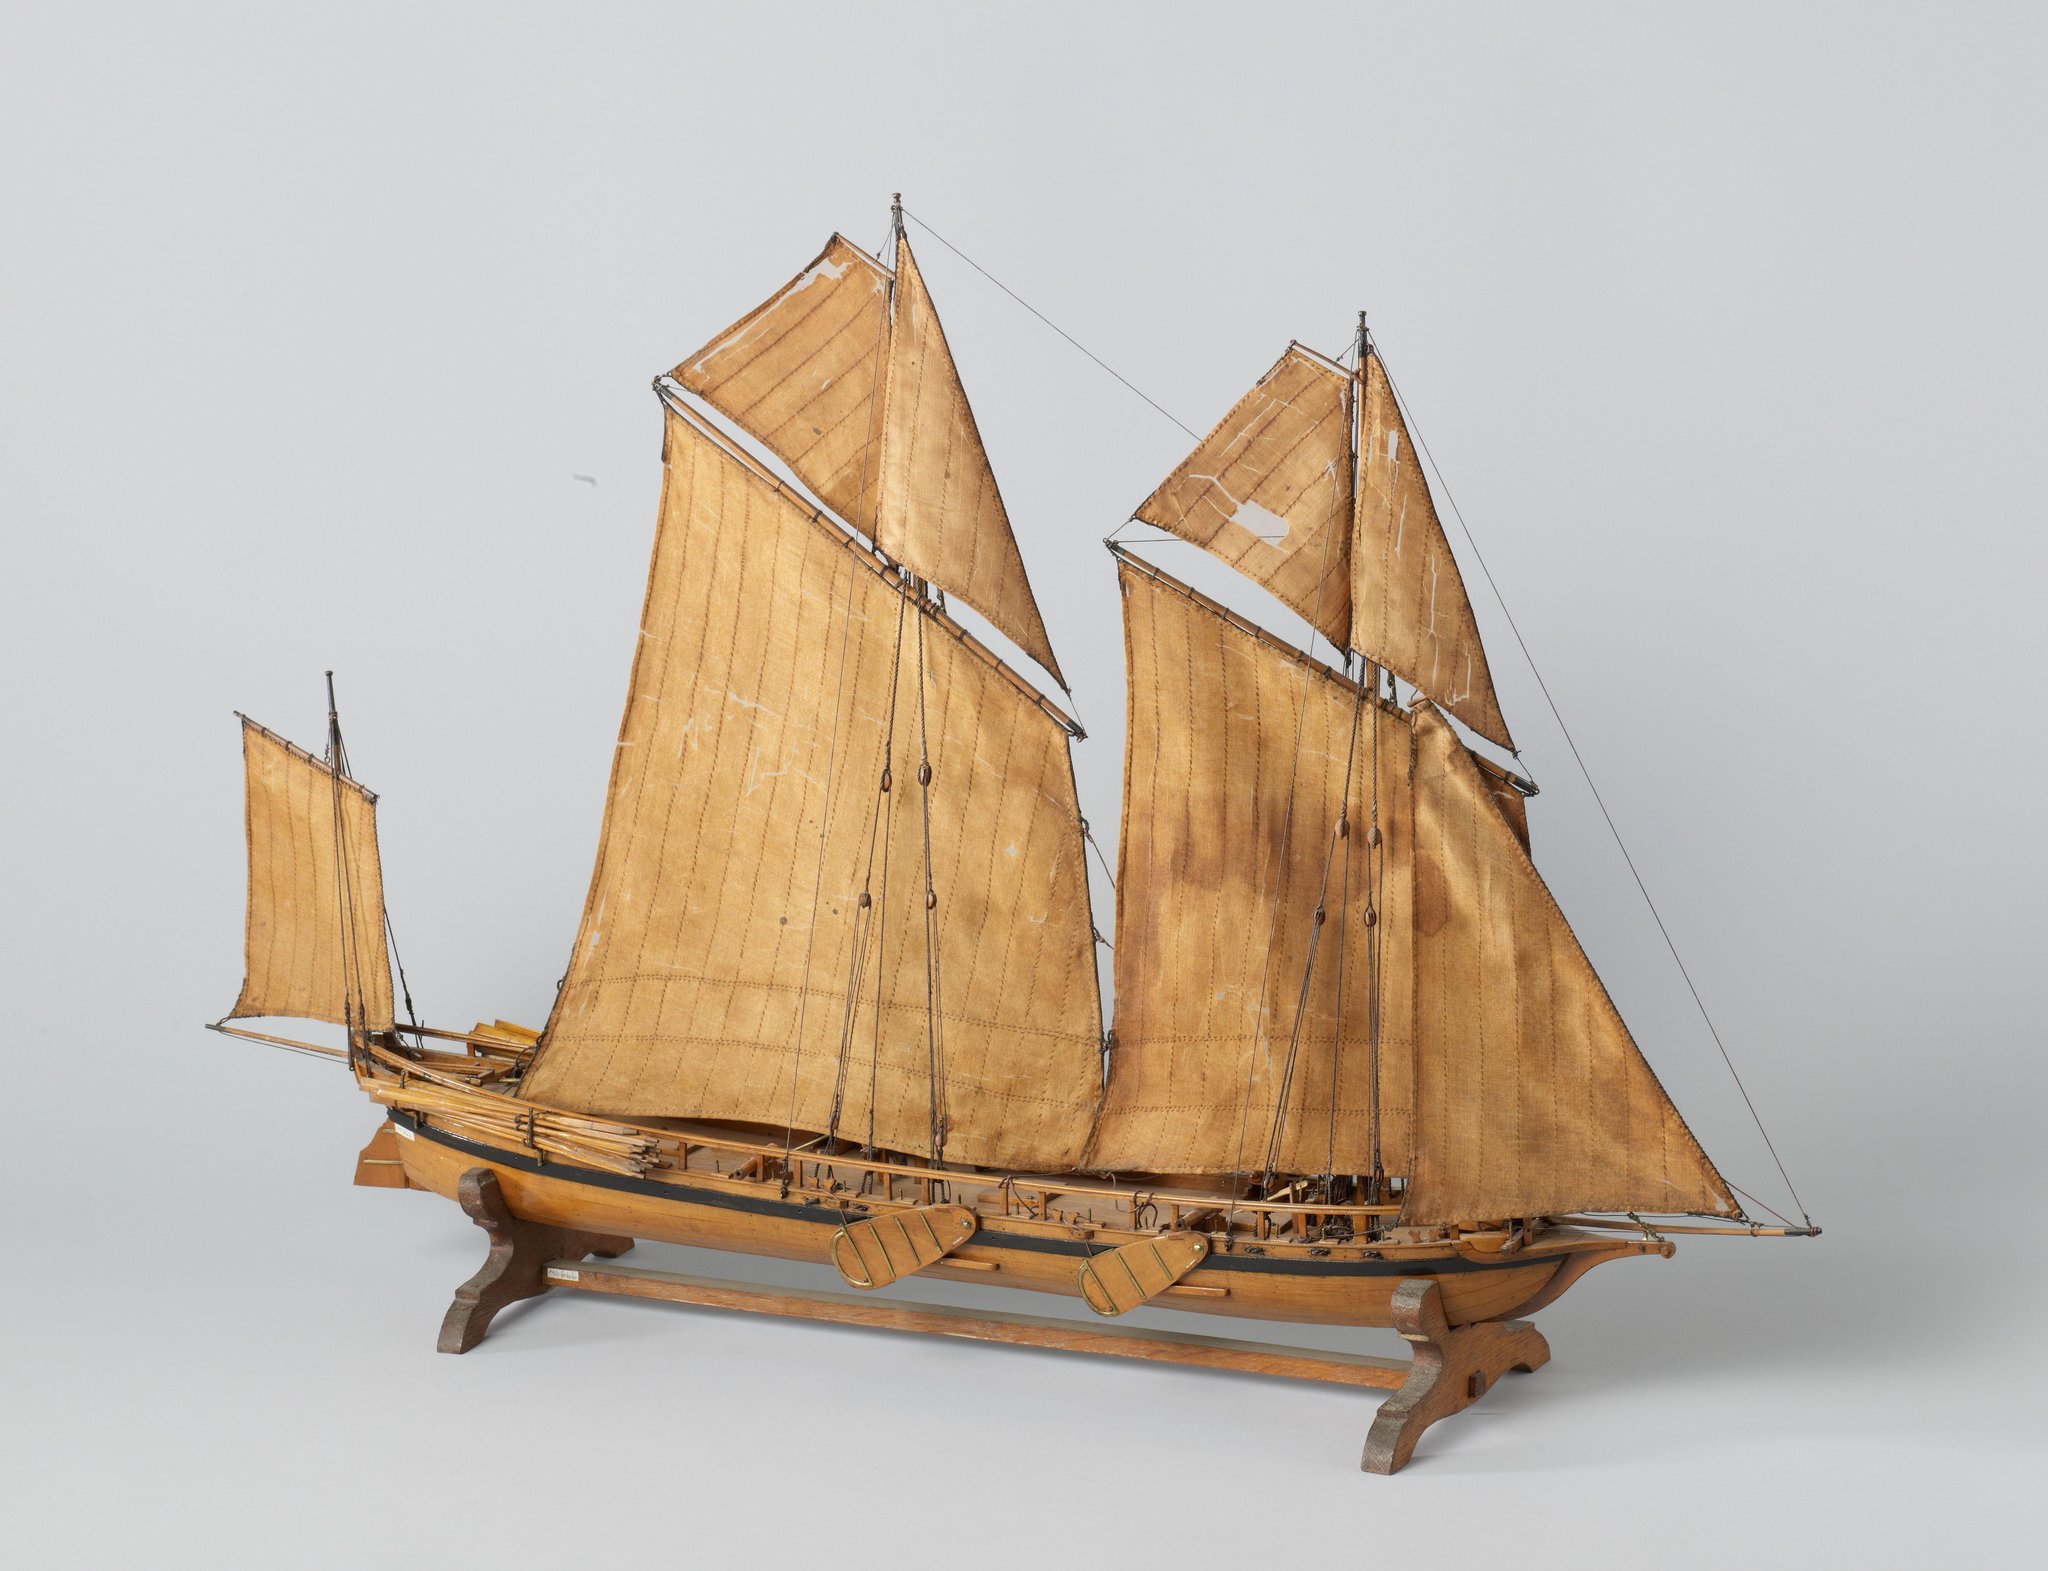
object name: ship model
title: Model of a War Galley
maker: jochem pietersz. asmus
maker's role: constructeur, directeur, equipagemeester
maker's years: 1755-1837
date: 1800-1807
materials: brass, fiber, textile, wood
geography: netherlands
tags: zeeduivel (schip)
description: De kanonneergalei van 5 tot 7 stukken Zeeduivel, lang 91 voet, was een platbodem logger in 1799 door de Marine te Amsterdam gekocht en door Asmus tot kanonneergalei omgebouwd. Het scheepstype wordt beschreven als kanonneerboot, roeikanonneerboot of kanonneergalei. Zij deed dienst op de Waddenzee tot zij in 1807 werd gesloopt.